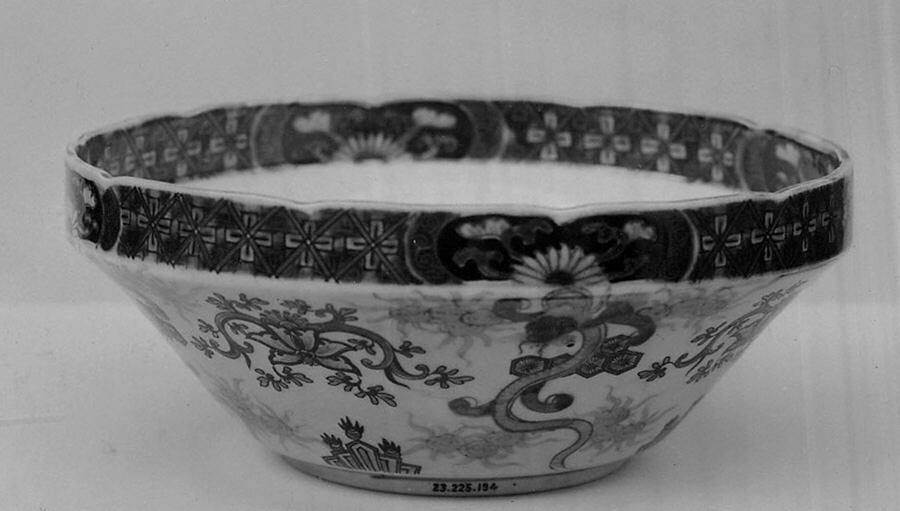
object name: bowl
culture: japanese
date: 1840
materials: enamel, porcelain